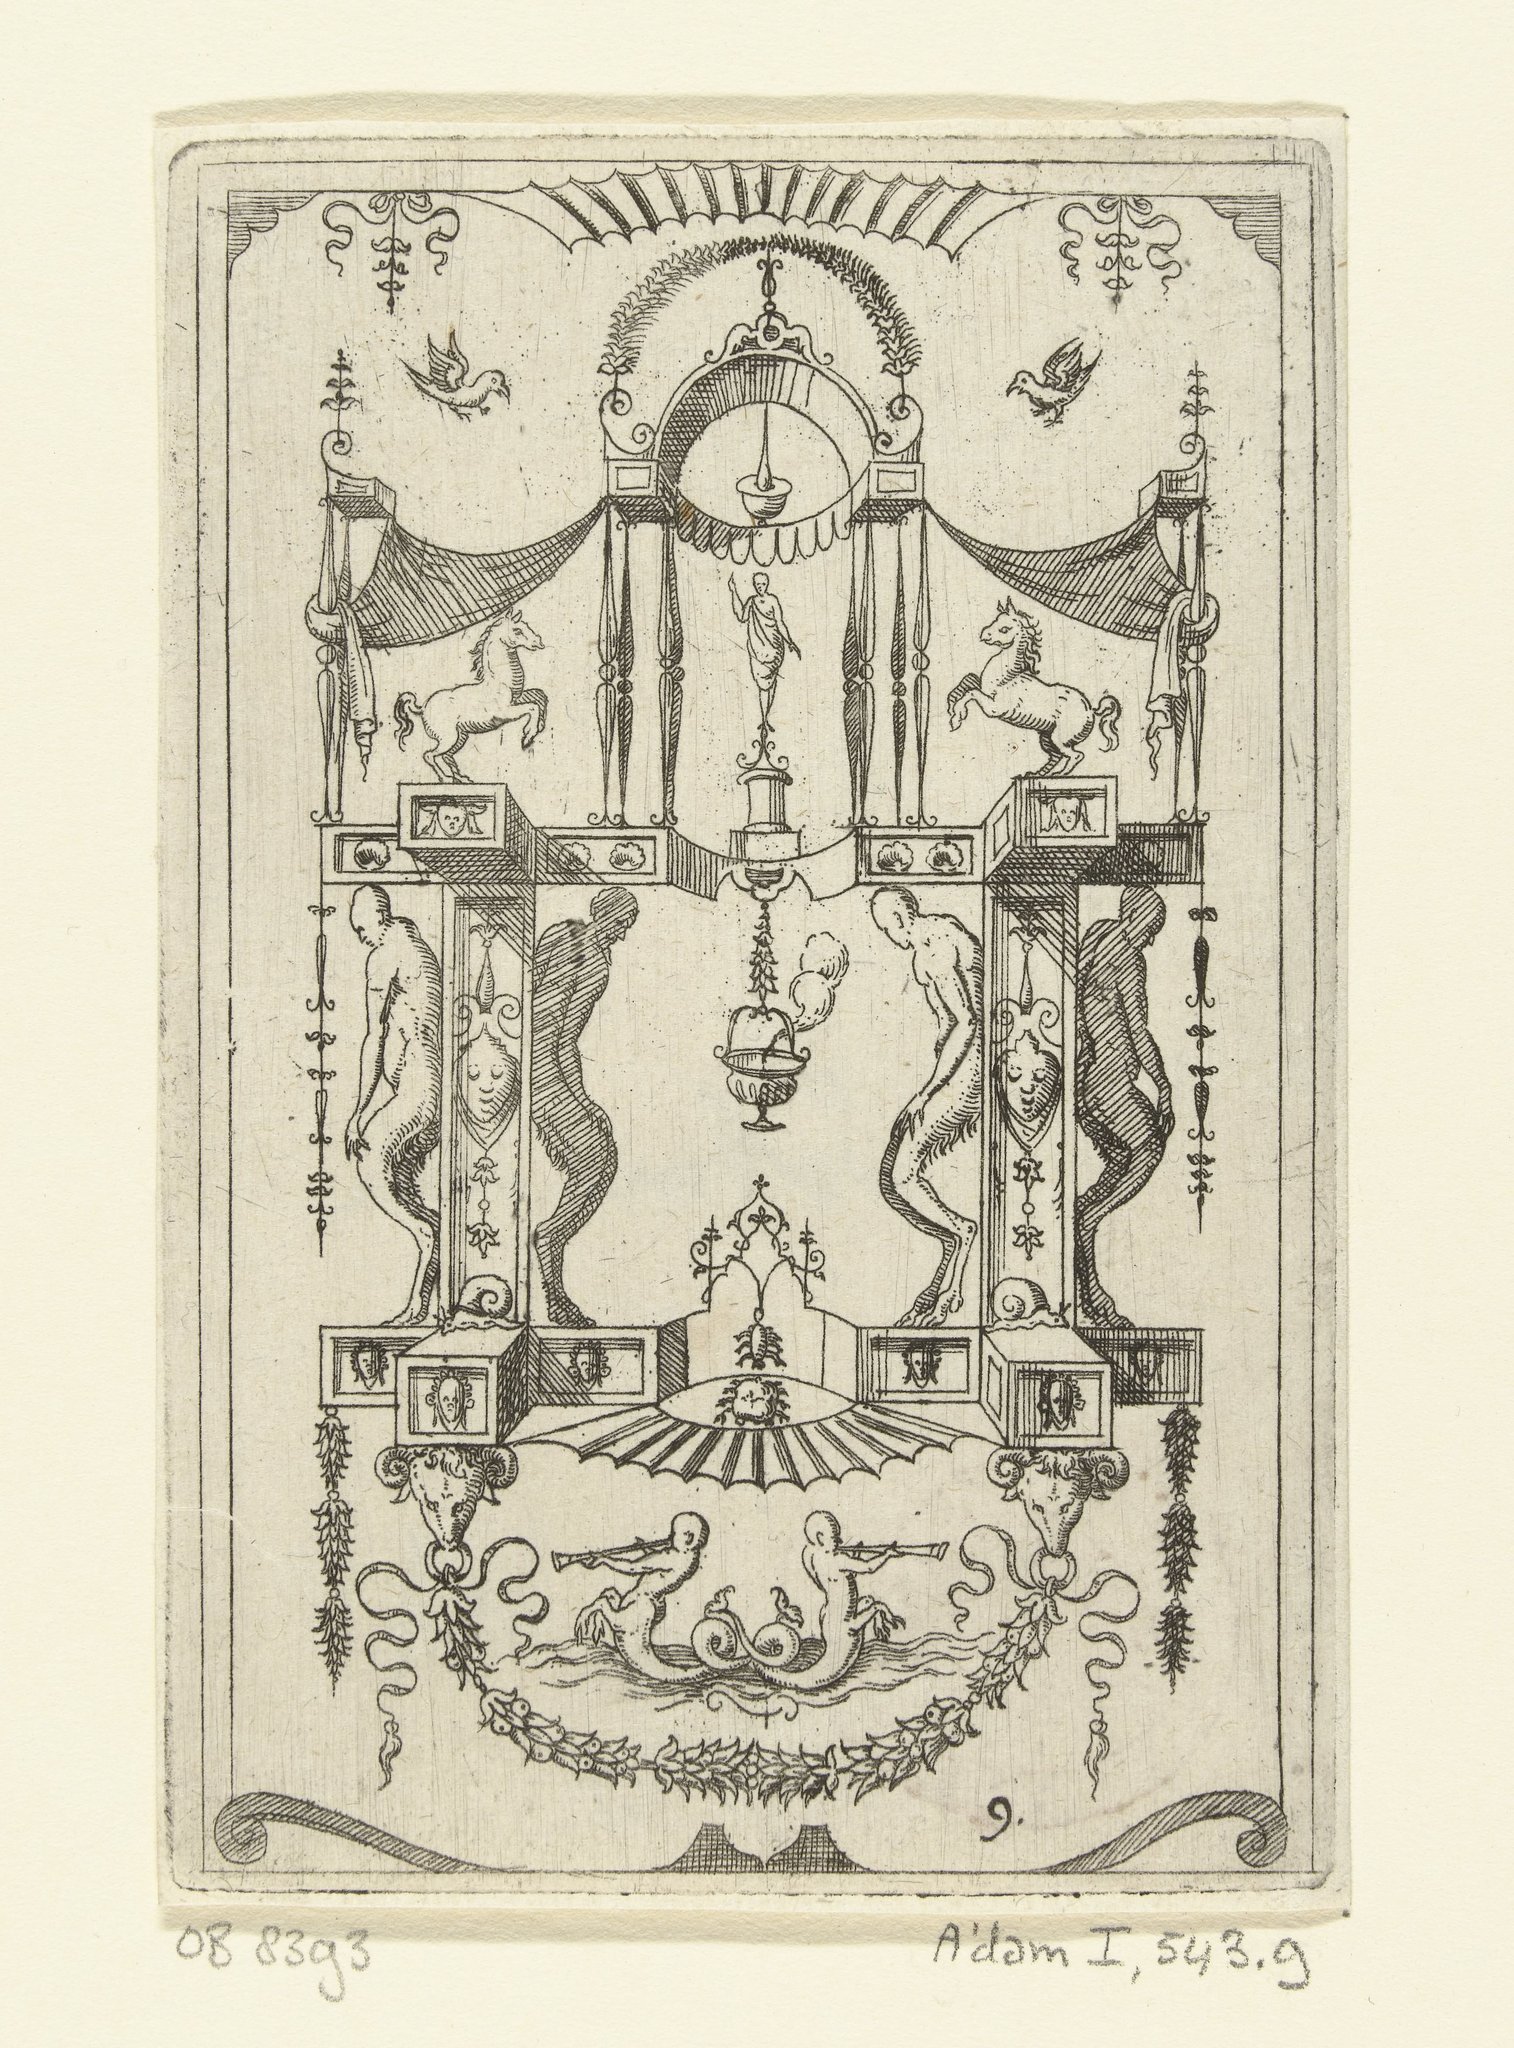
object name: ornament print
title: Iacobus Androuetius Du Cerceau inventor ante annos non paucos conscripsit (...)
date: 1525-1594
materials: paper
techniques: etching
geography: netherlands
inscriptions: collector's mark: Lugt 240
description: Kopie naar prent van Jacques Androuet Ducerceau, ontleend aan een vlakdecoratie van Enea Vico. Blad uit serie met architectuurfantasieën en grotesken met fabelwezens, guirlandes, kandelabers en mascarons.